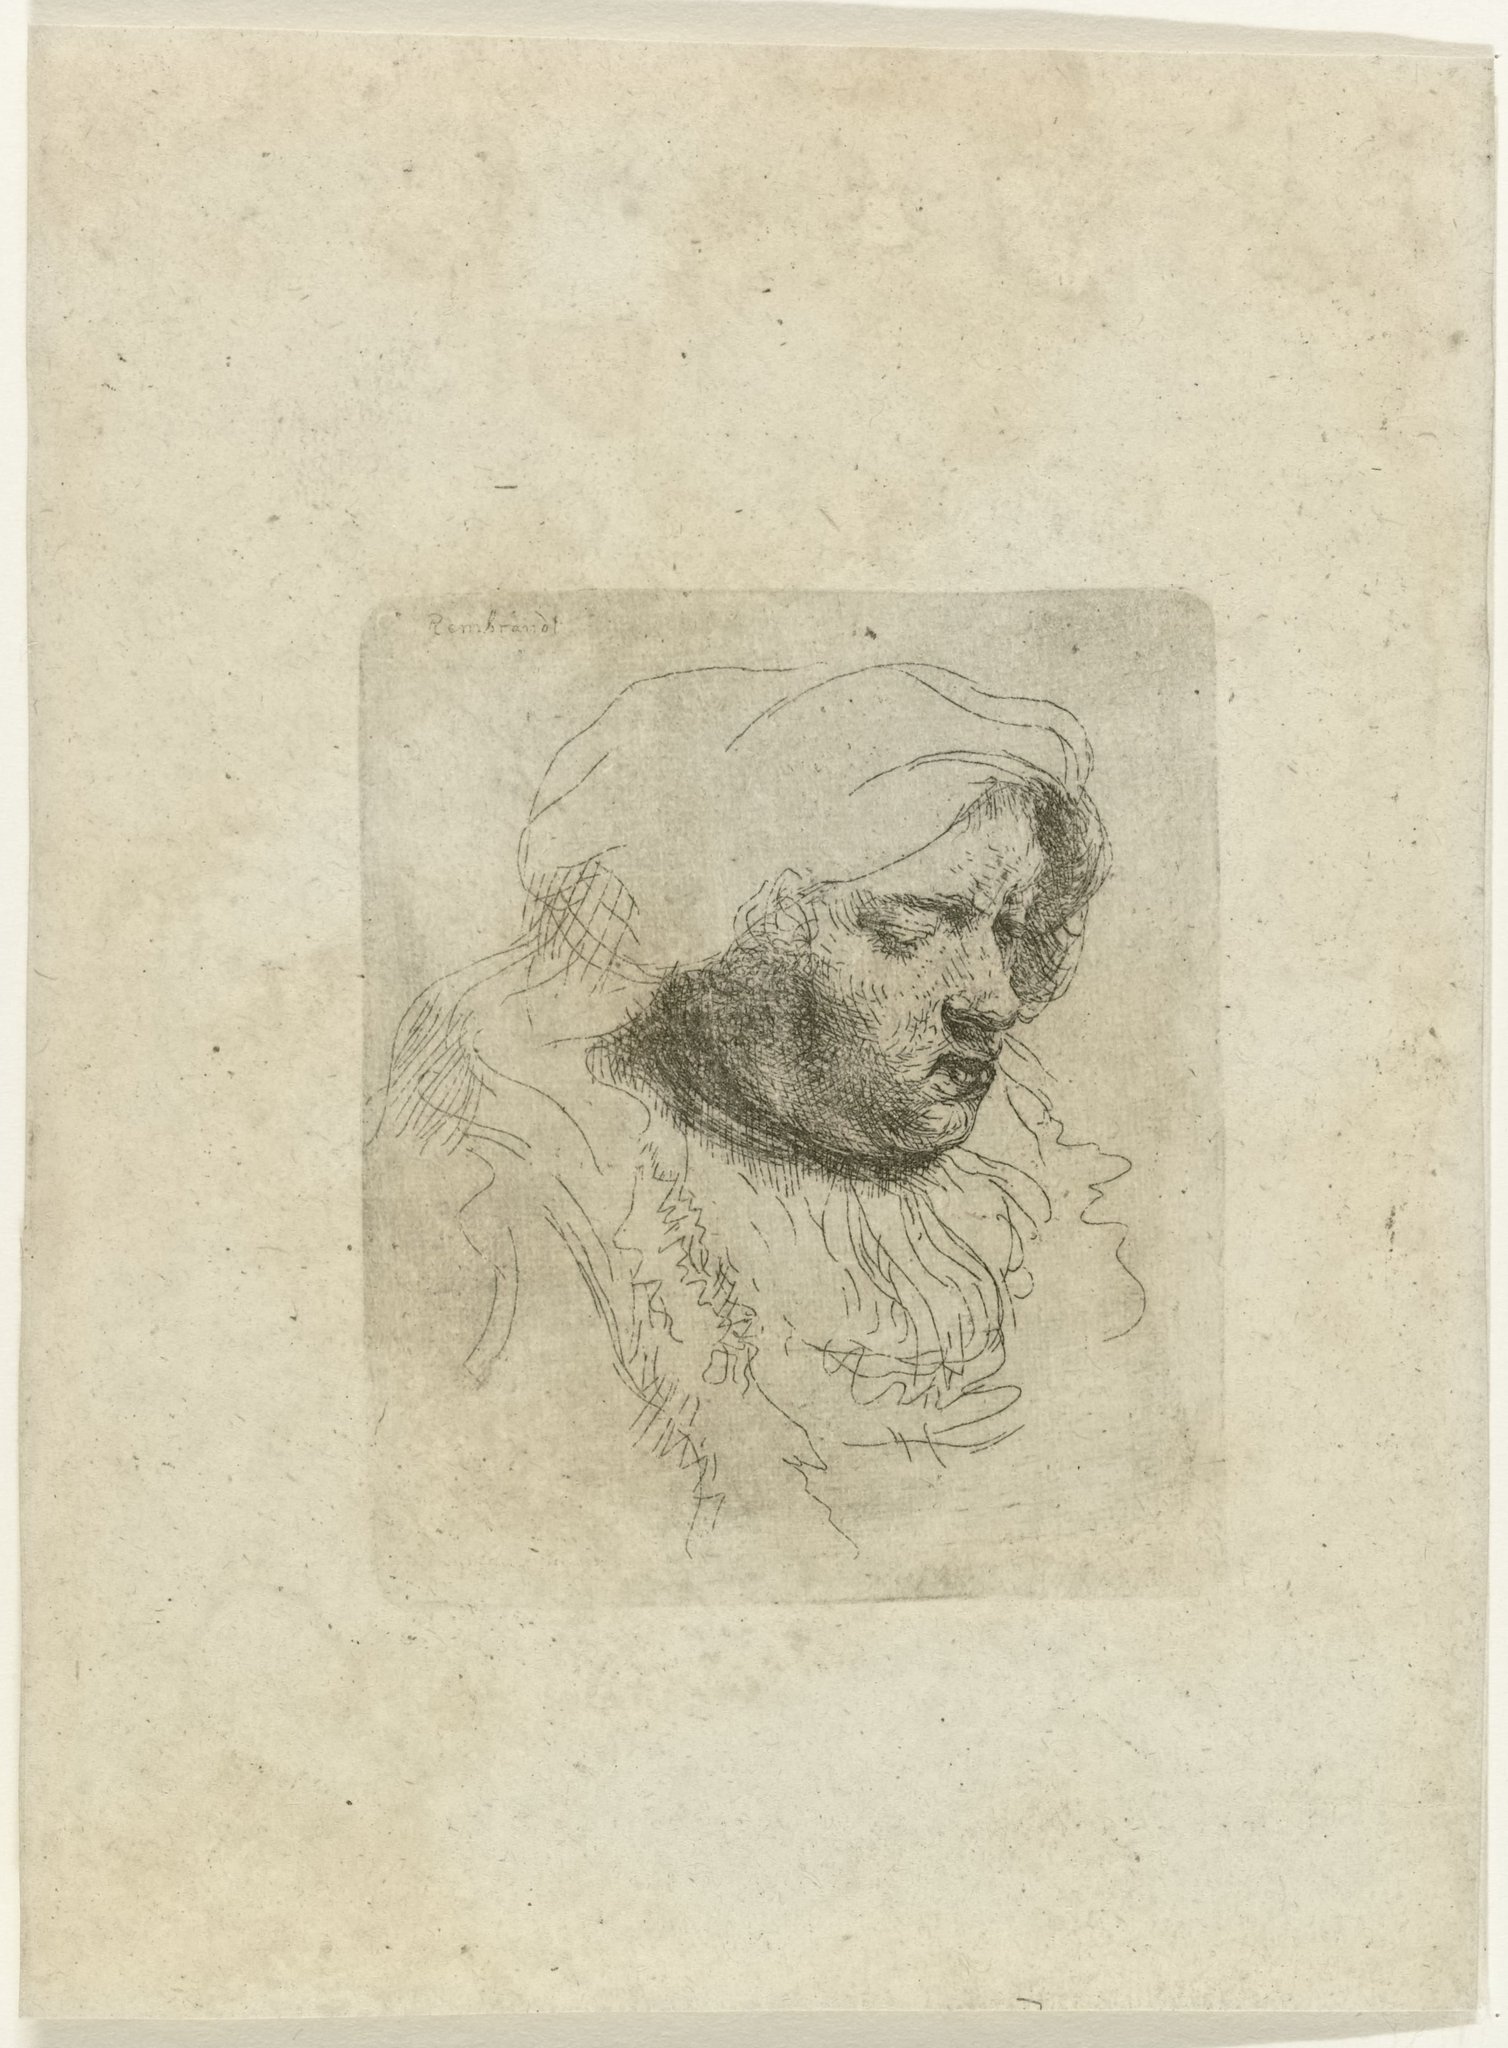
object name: print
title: Buste van vrouw met doek over hoofd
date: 1728-1786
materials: paper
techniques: etching, intaglio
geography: france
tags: chest, bust, adult woman (+ sideview, profile)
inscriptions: collector's mark: Lugt 2228